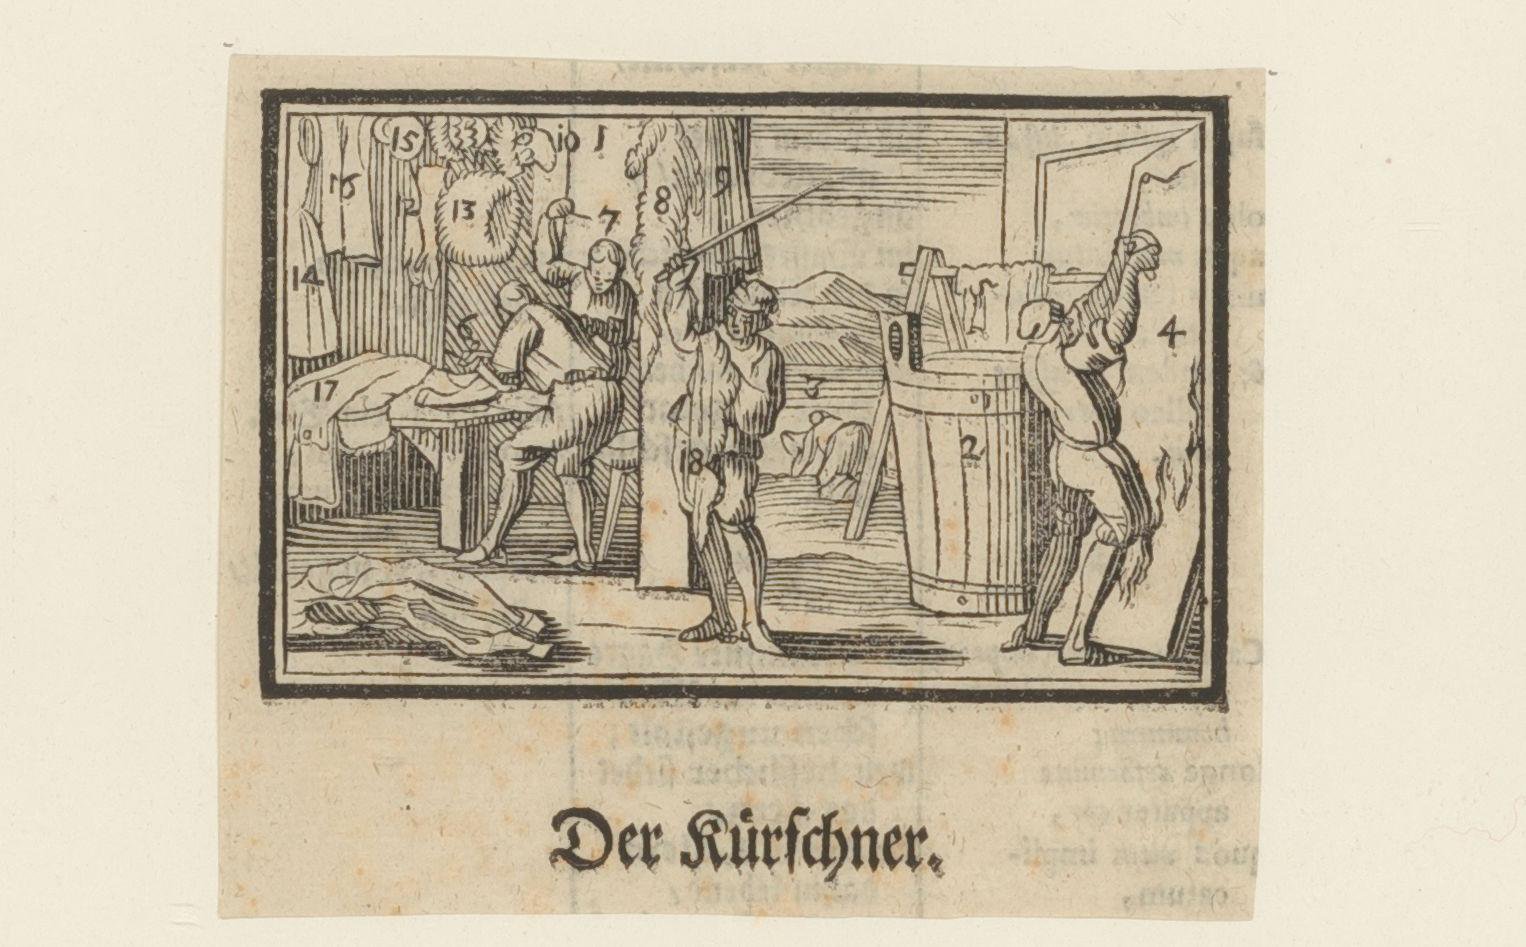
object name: book illustration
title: Villen van huiden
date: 1719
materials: paper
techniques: letterpress printing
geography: nuremberg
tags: handicrafts, craftsman at work, skins, leather ~ building material, weaving, textile fabric, cloth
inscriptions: collector's mark: Lugt 1641, stamp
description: Prent uit: Comenius, Johannes Amosius. Orbis sensualium picti pars prima (...). Neurenberg: Martin Endter, 1719, dl. 2, p. 200. Prent eerder gebruikt in: Comenius, Johannes Amosius. Orbis Sensualium Picti denuo aucti Pars Secunda (...). Neurenberg: Martin Endter, 1730, dl. 2.